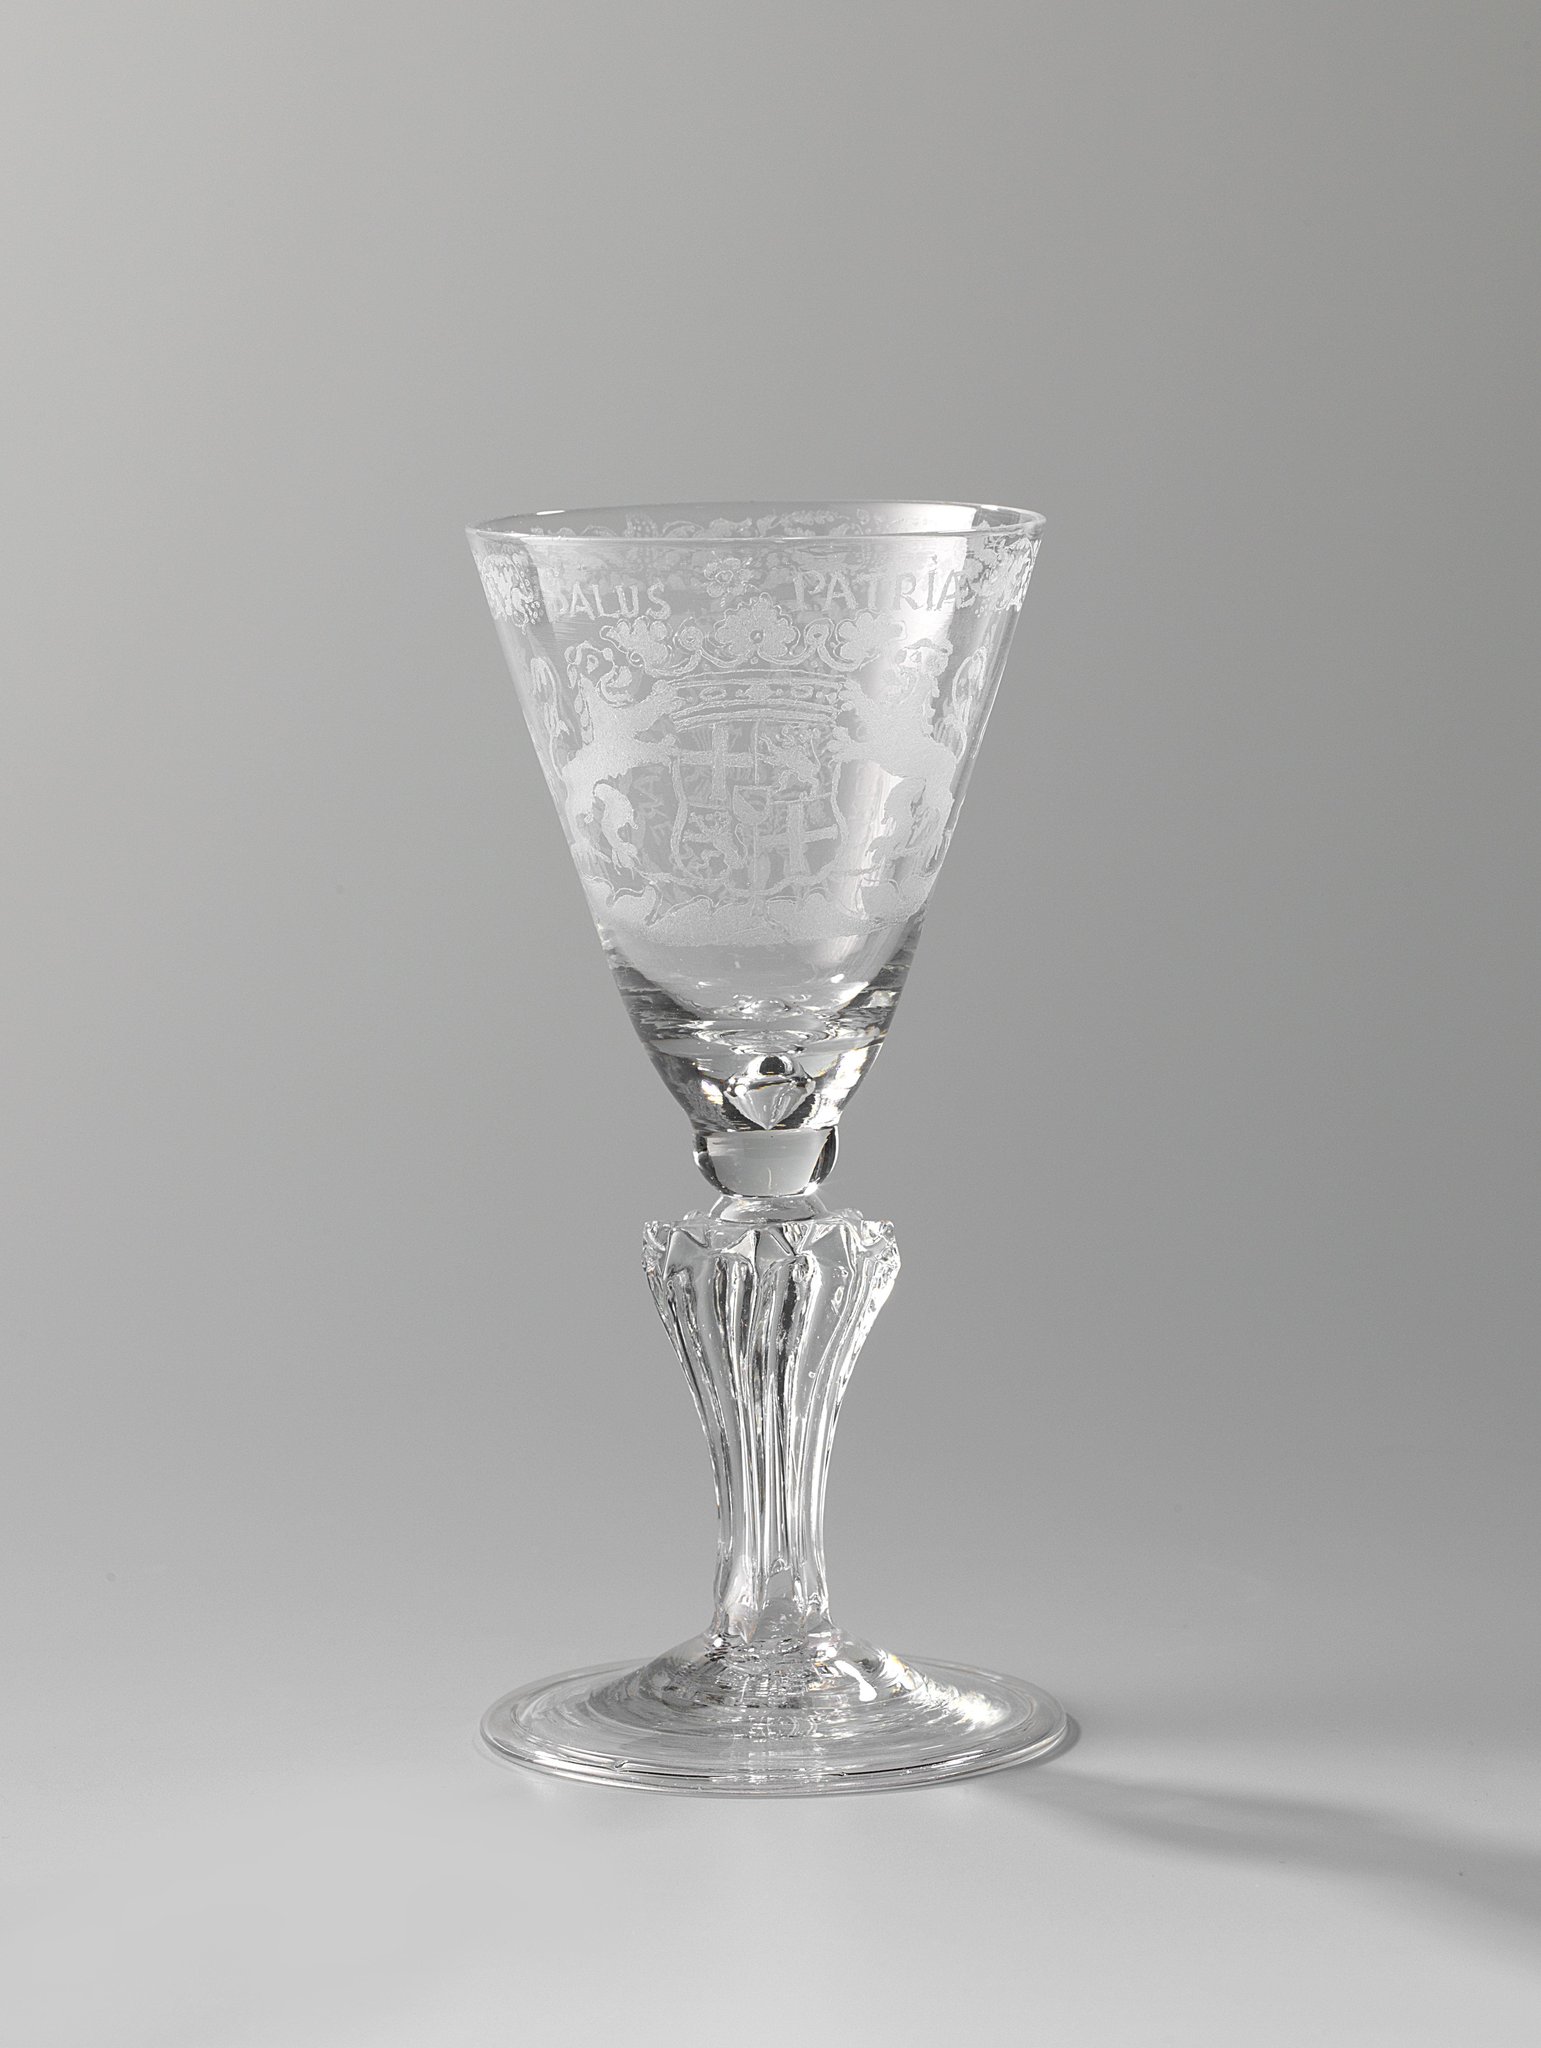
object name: goblet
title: Wine glass with the arms of the province of Utrecht and a soldier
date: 1725-1750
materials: glass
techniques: diamond point engraving, glassblowing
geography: utrecht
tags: coat of arms (as symbol of the state, etc.) (+ province; provincial)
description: translation of inscription: The Prosperity of the Country / Union is Strength